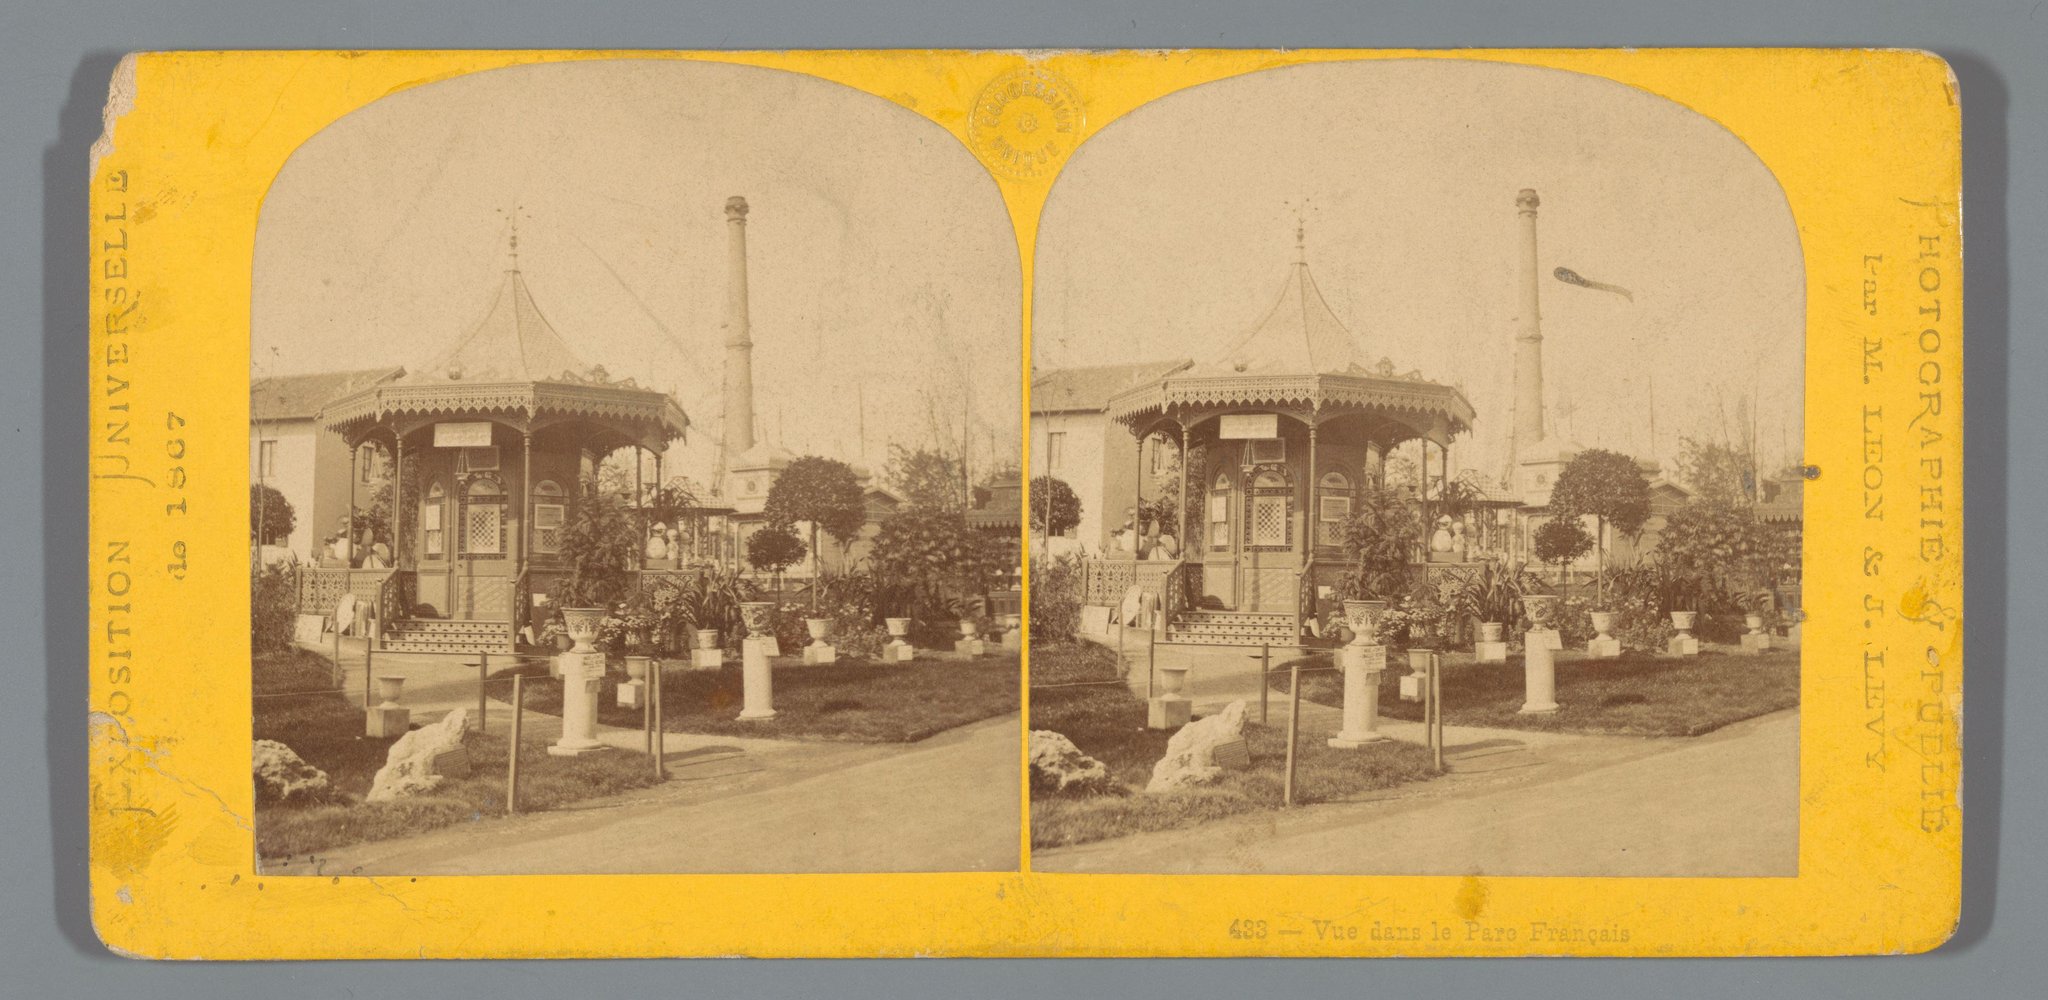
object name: stereograph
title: Vue dans le parc français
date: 1867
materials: cardboard, paper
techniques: albumen print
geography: paris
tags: park, world fair, world exhibition, paris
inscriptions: check stamp: ‘CONCESSION/ */ UNIQUE’, number: ‘433’